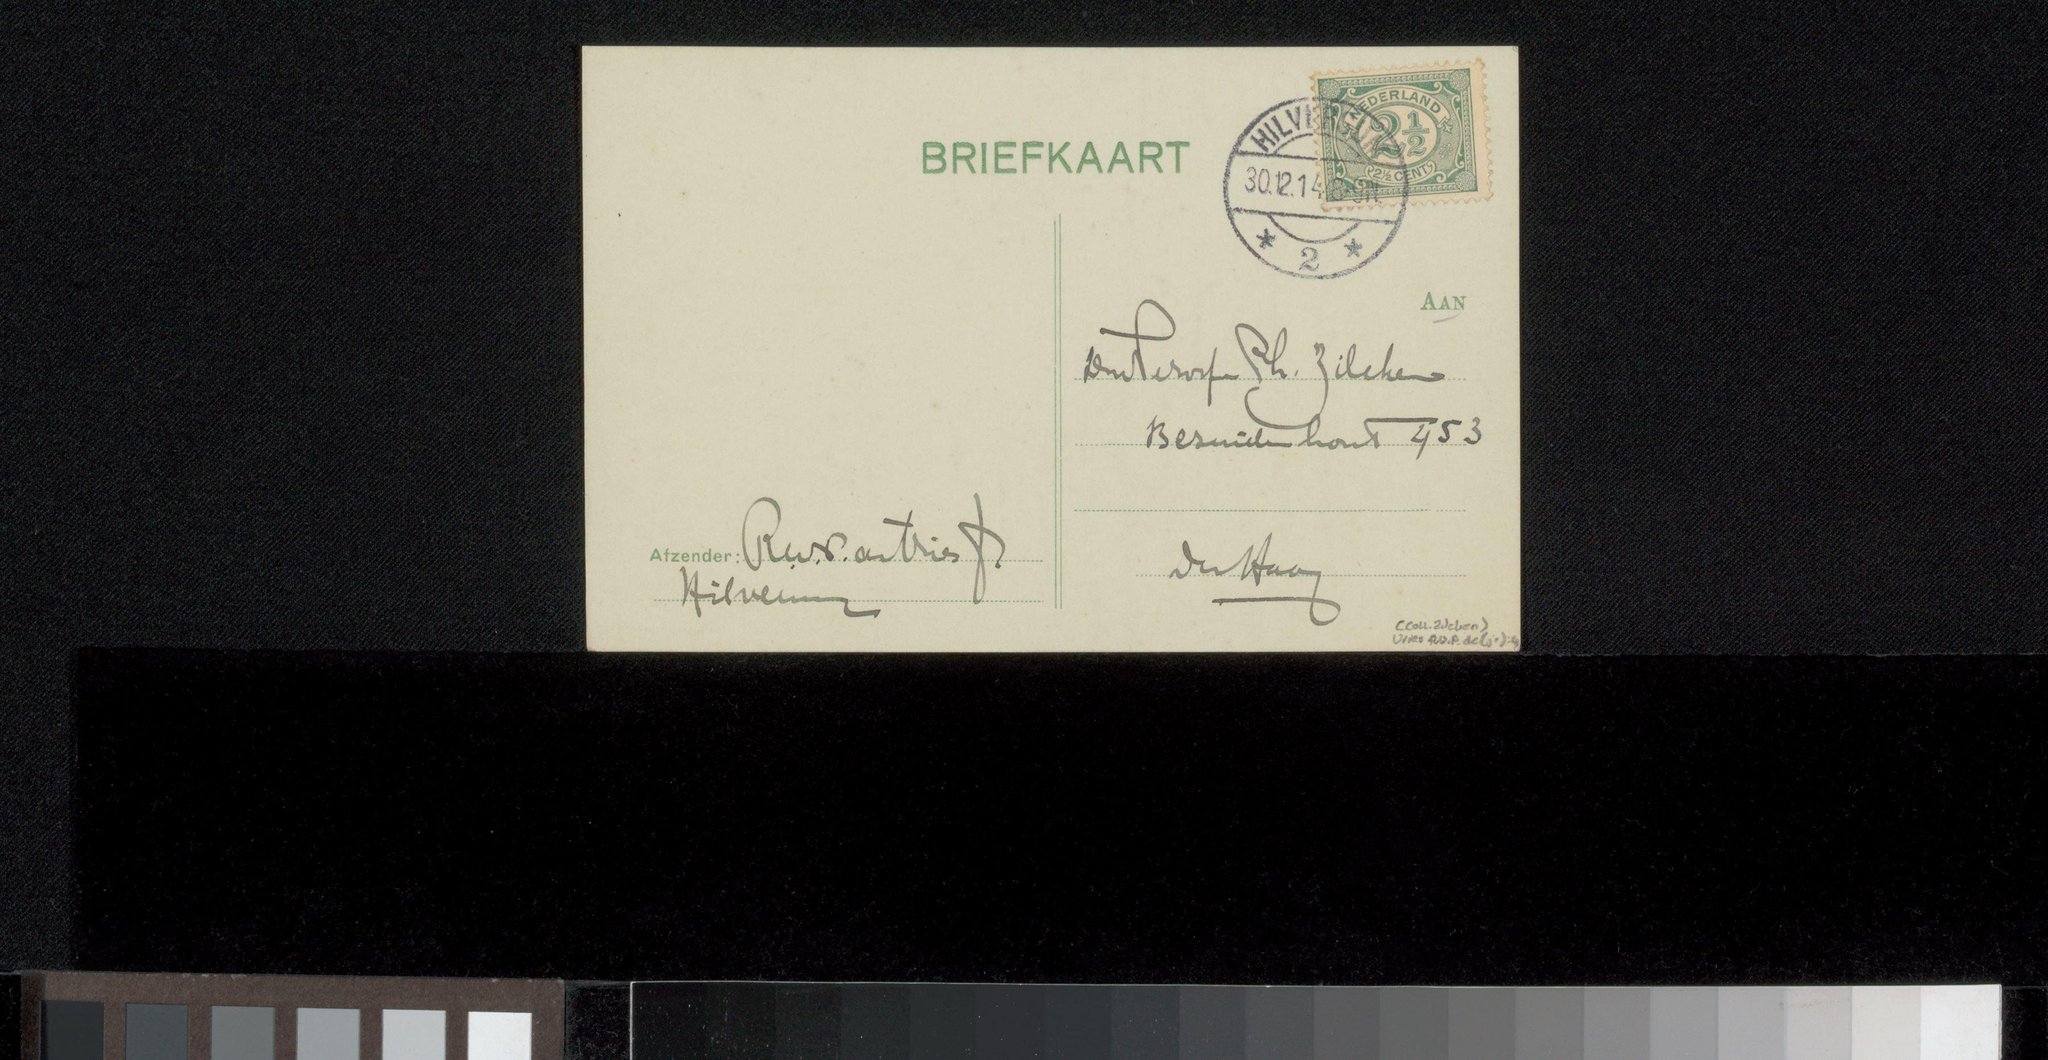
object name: postcard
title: Briefkaart aan Philip Zilcken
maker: reinier willem petrus de vries (1874-1953)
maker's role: draughtsman, print maker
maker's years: 1874-1953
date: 1914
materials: cardboard, ink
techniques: pen, writing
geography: hilversum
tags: the hague, painter, philip zilcken, drawing, photography, cinematography, the graphic arts, printed matter